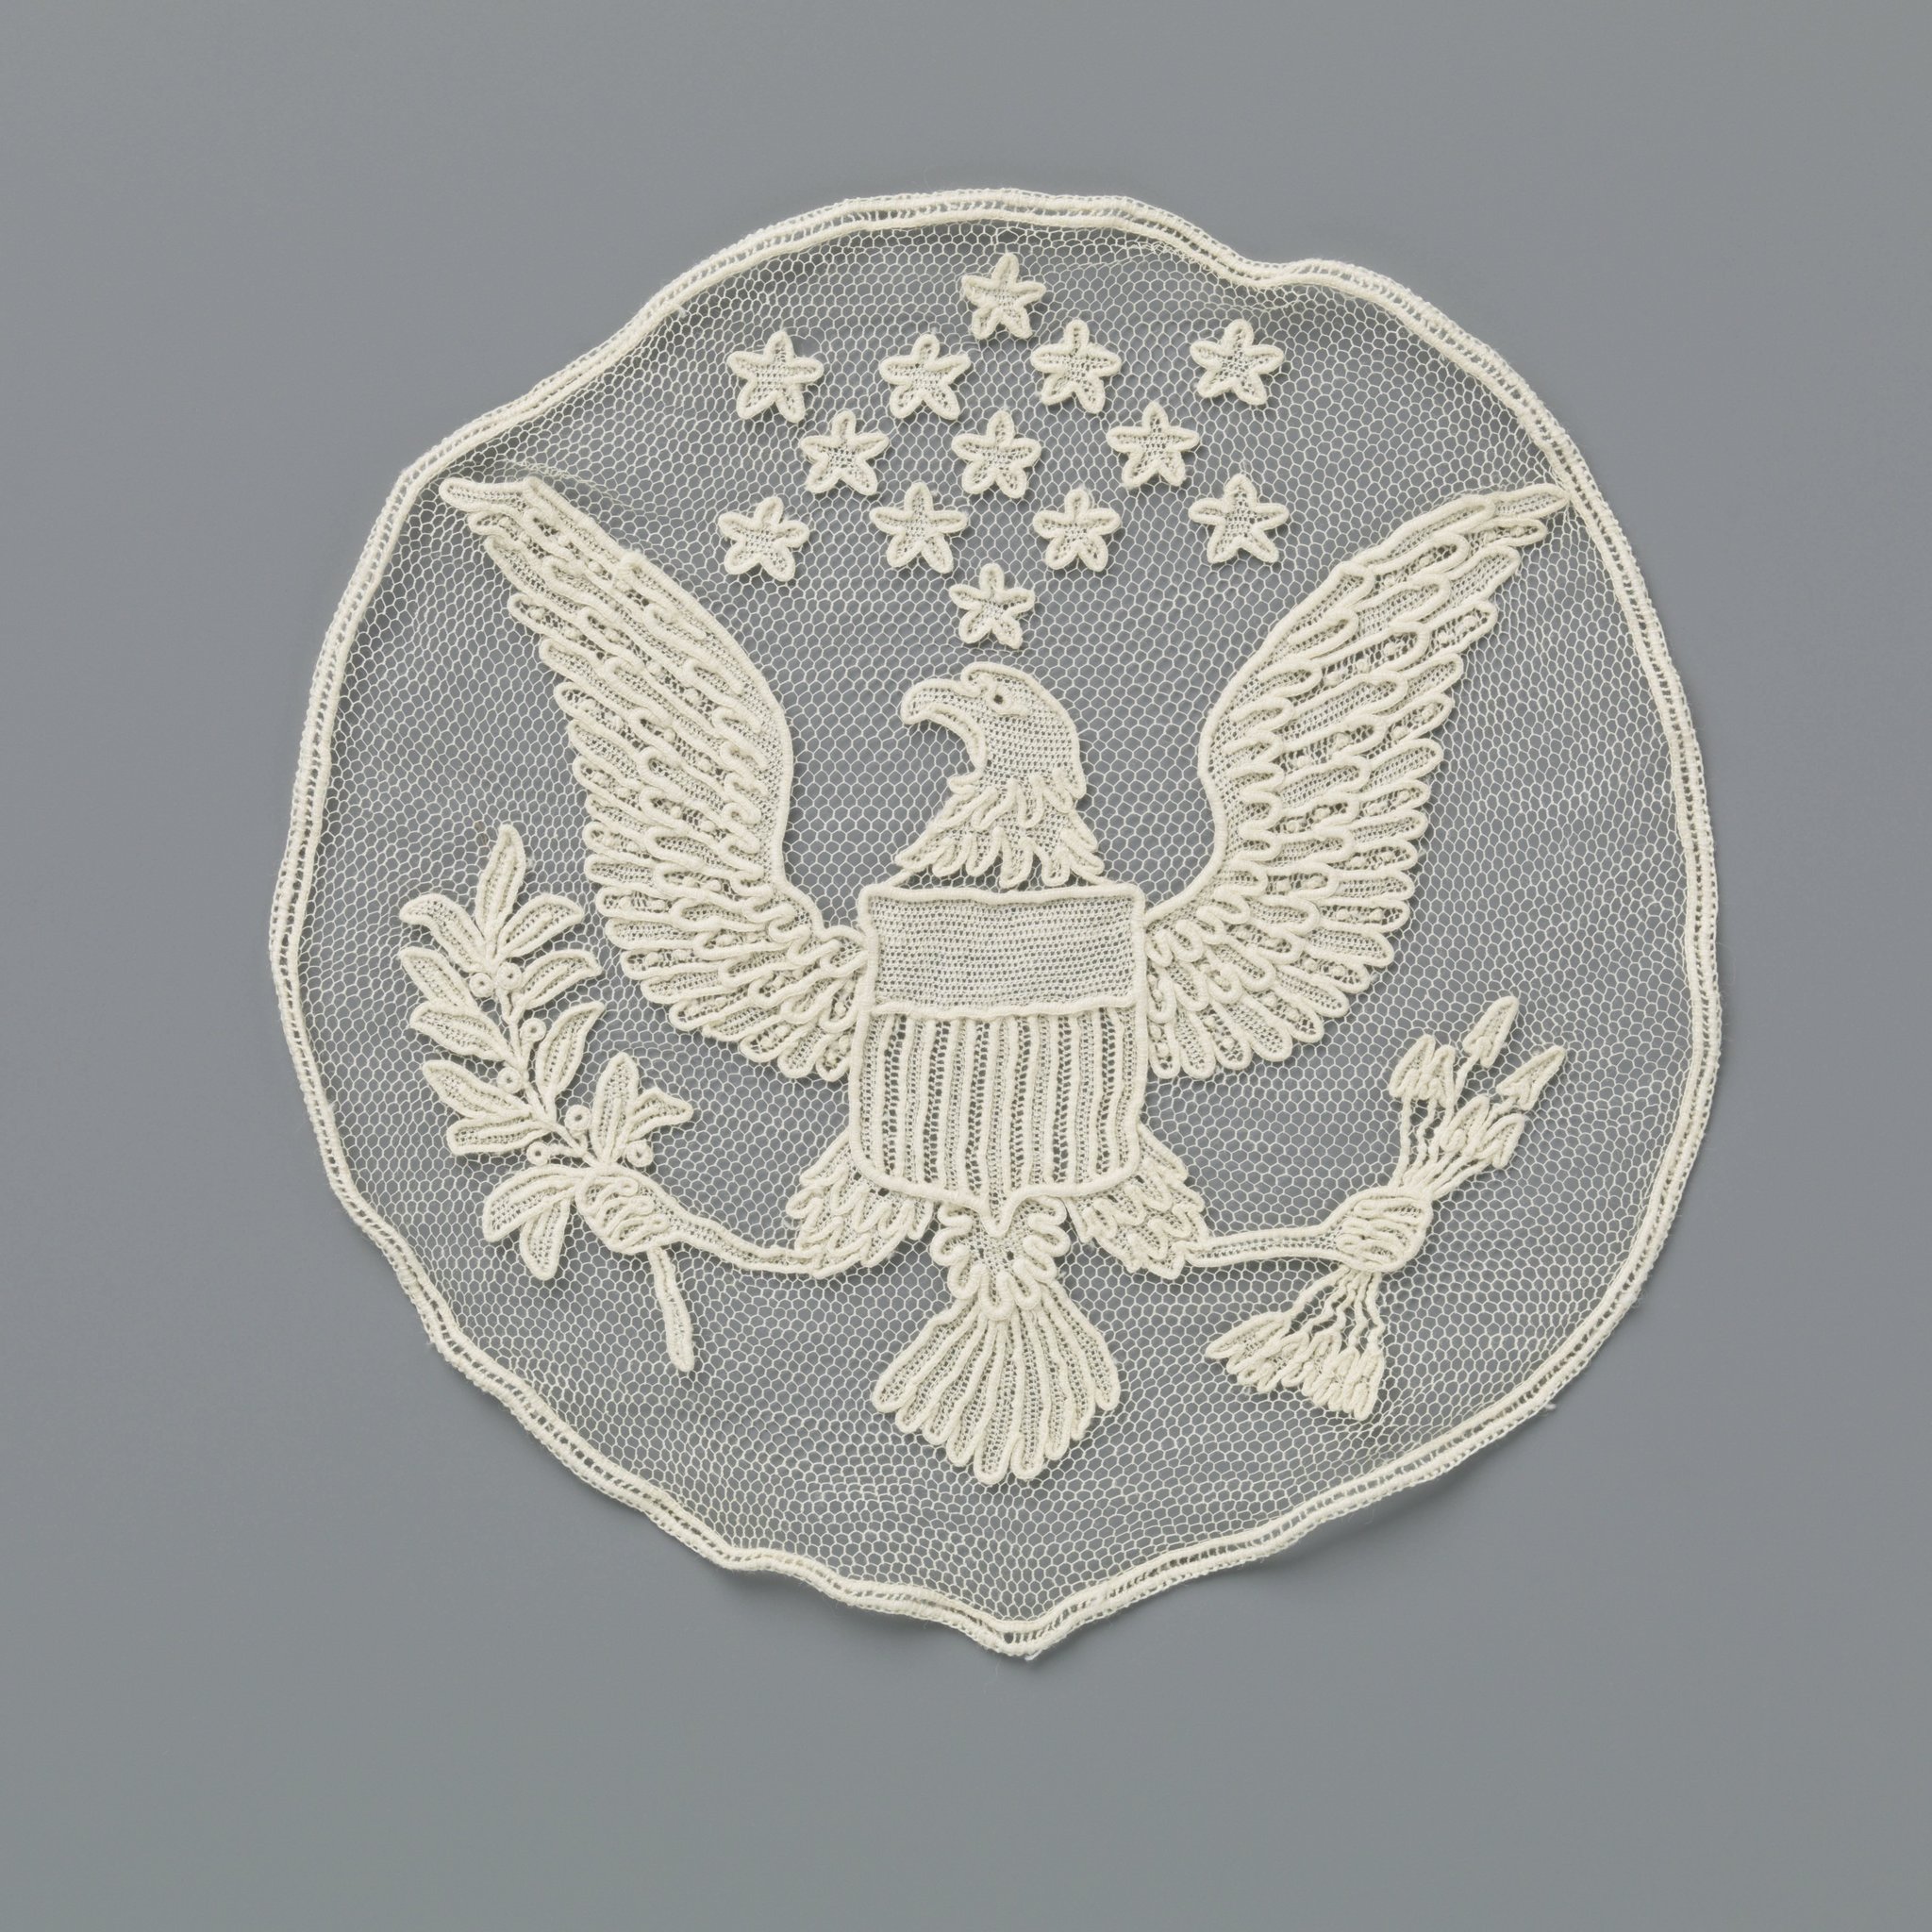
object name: inzetstuk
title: Inzetstuk van naaldkant met het wapen van de V.S.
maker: Anonymous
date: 1914-1918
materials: linen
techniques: needle lace, lace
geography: belgium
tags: armorial bearing, heraldry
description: Inzetstuk van naturelkleurig naaldkant: war lace. Rond model met daarop het wapen van de Verenigde Staten van Amerika, met een adelaar en sterren. Het inzetstuk was bedoeld voor een tafellaken waarop de wapens van de geallieerden zouden staan, met als thema de Vrede van Versailles.